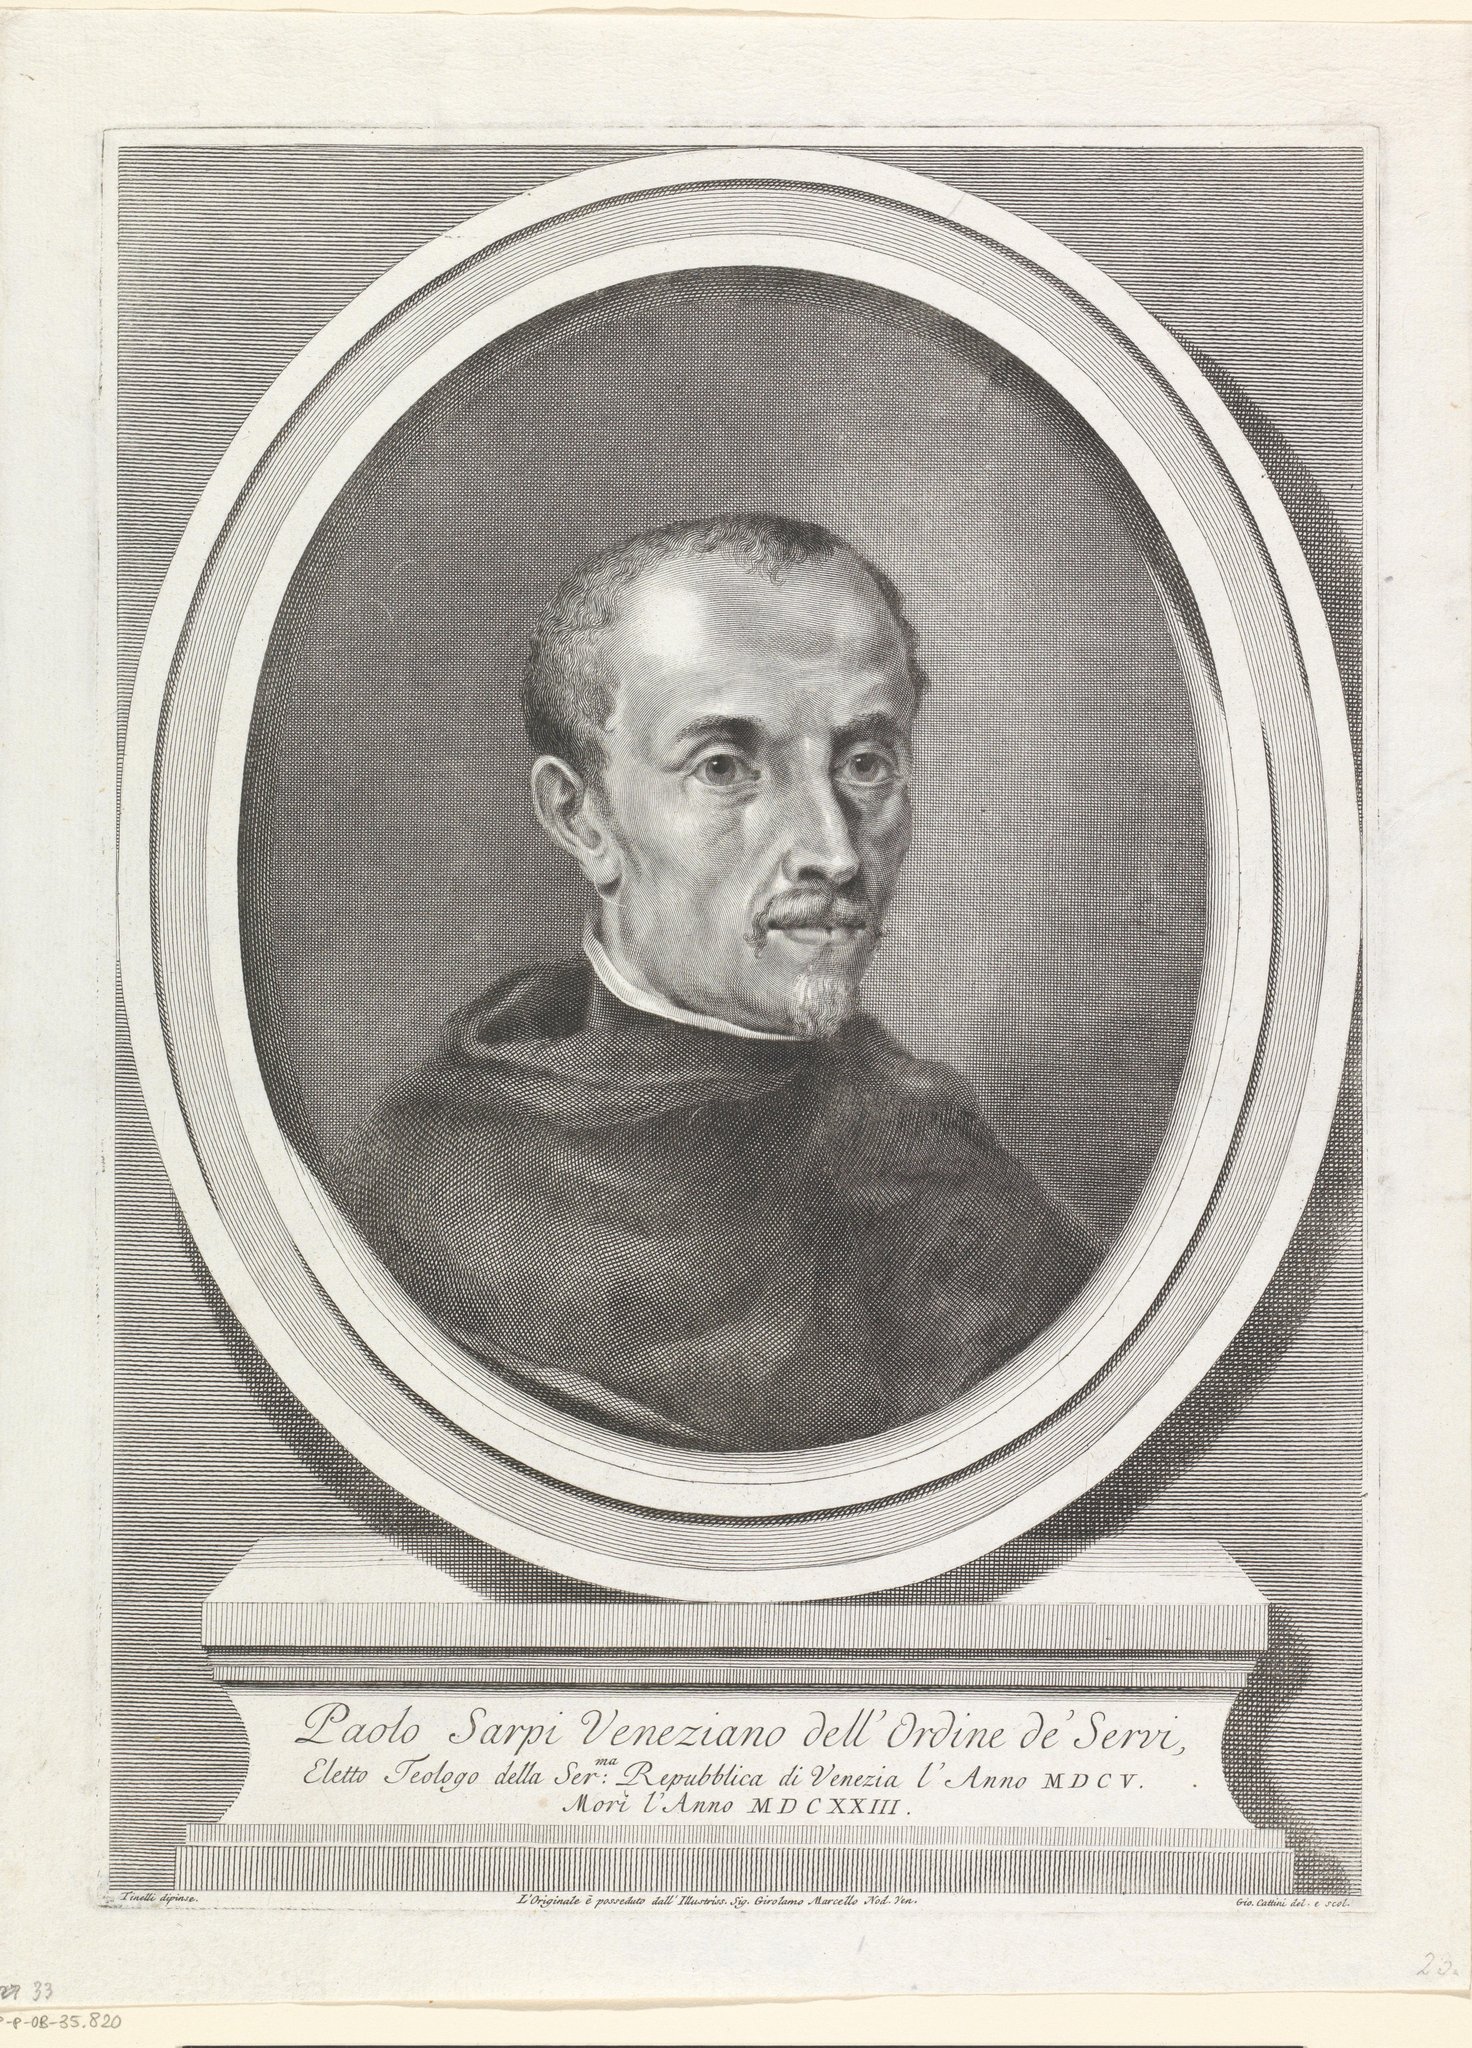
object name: print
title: Portret van Paolo Sarpi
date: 1735-1800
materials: paper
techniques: engraving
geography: italy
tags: venice, historical persons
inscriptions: collector's mark: Lugt 2165